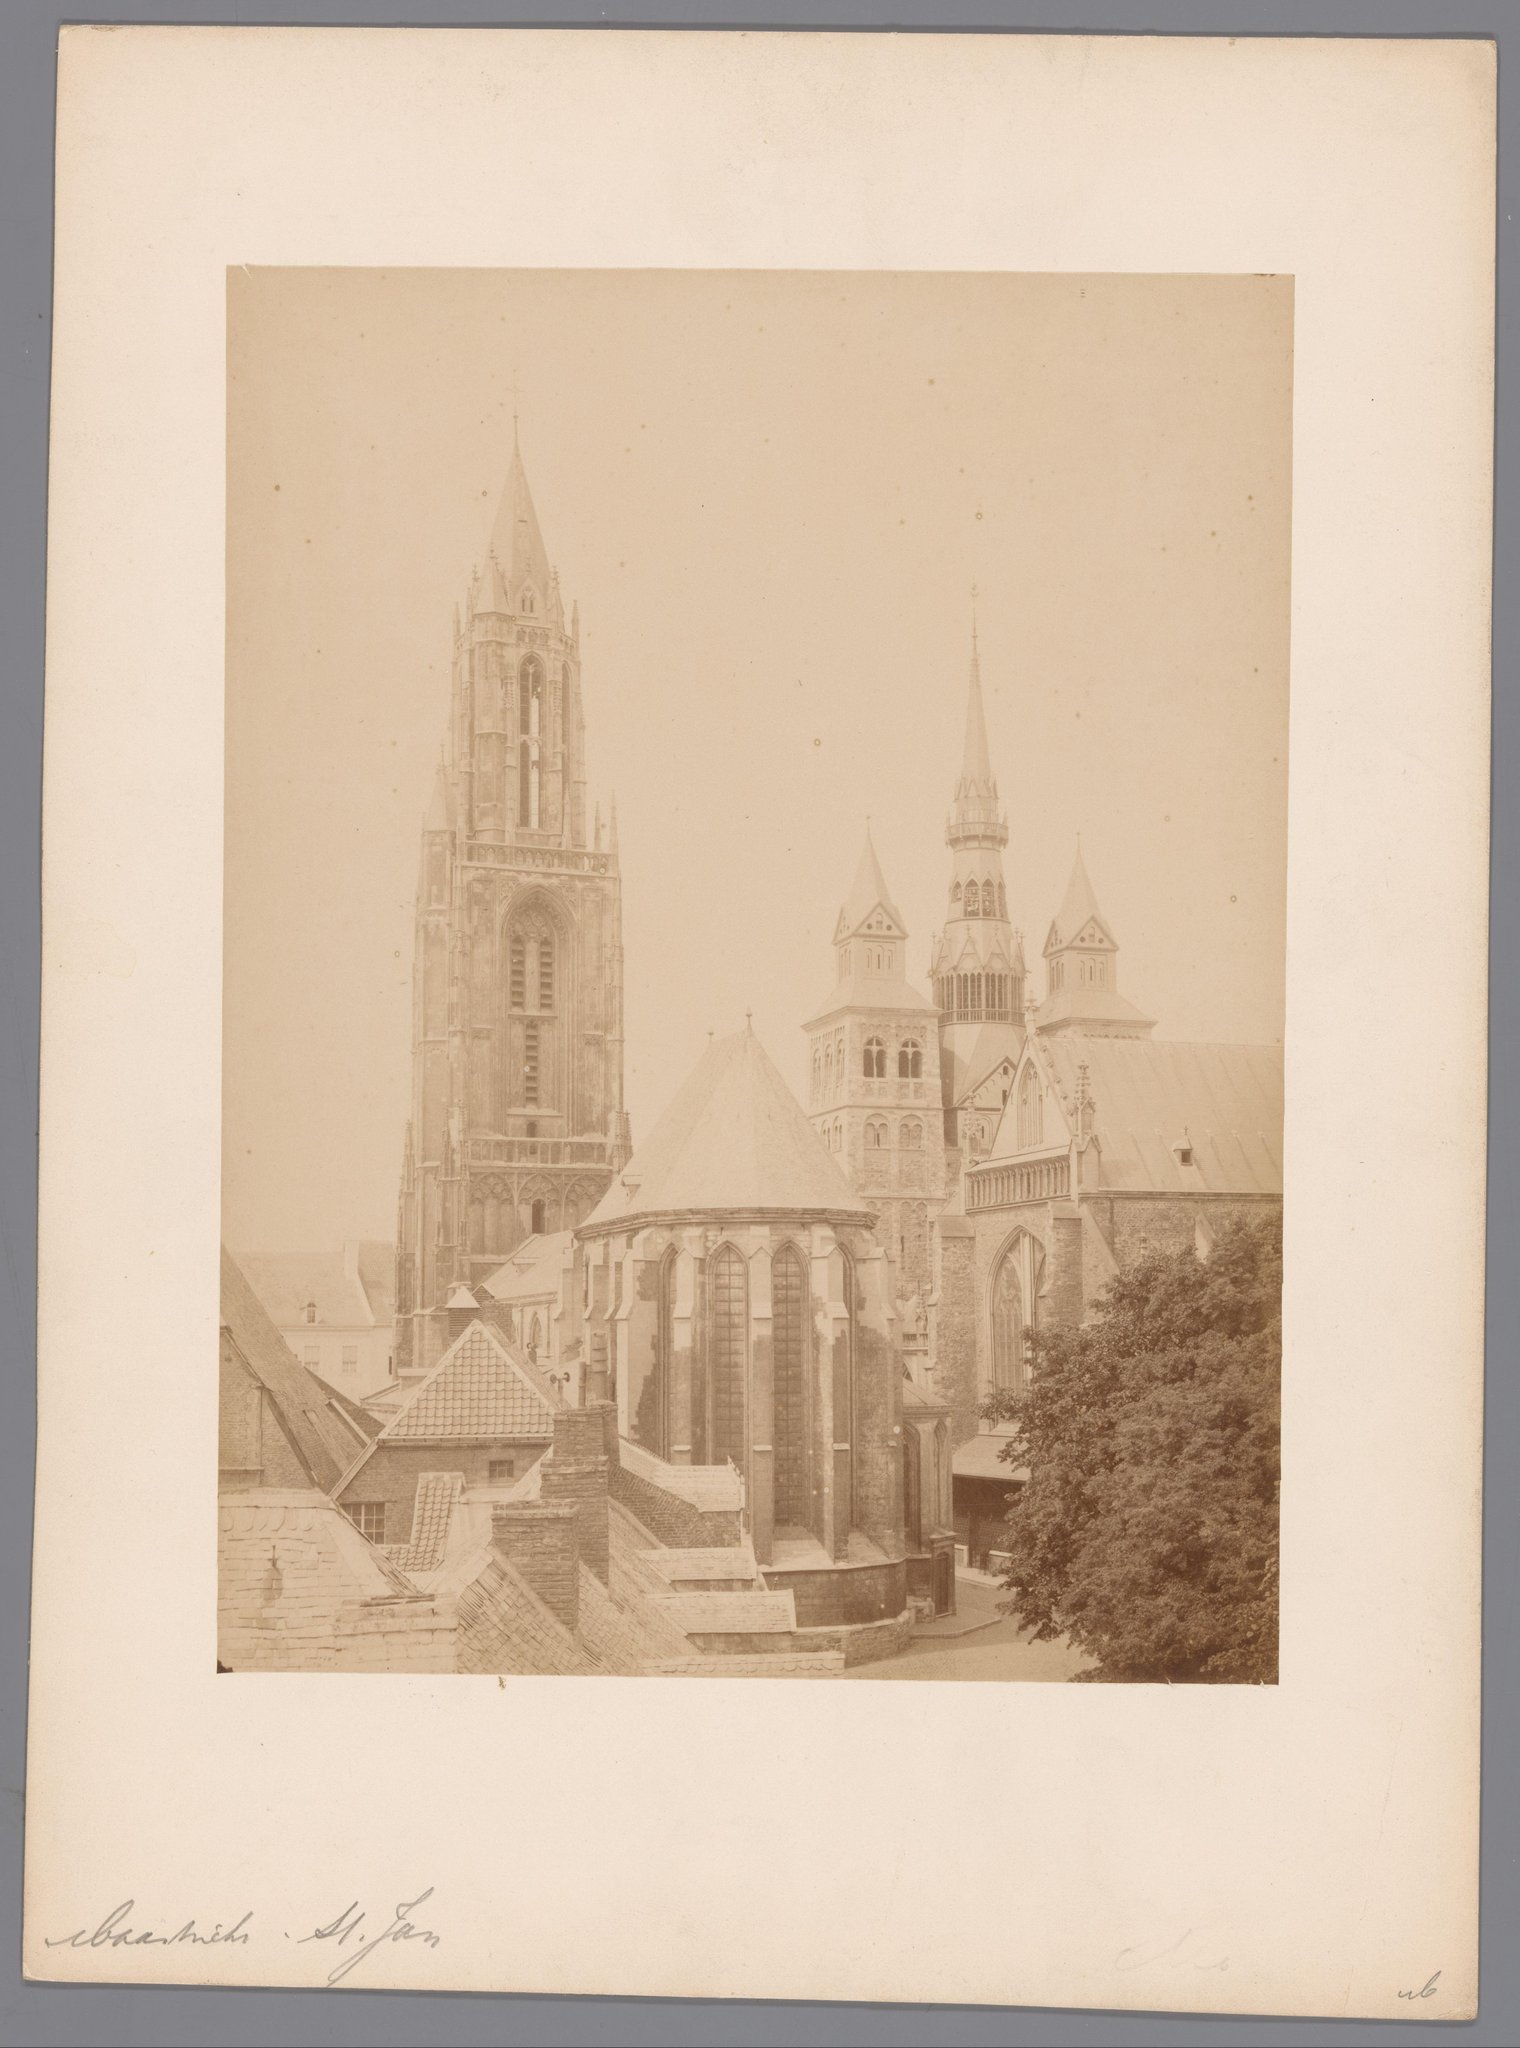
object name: photograph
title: Gezicht op de Sint-Servaasbasiliek en de Sint-Janskerk te Maastricht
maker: anoniem (monumentenzorg)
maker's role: fotograaf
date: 1893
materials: cardboard, photographic support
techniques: albumen print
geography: maastricht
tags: church (exterior)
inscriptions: annotation: ‘Maastricht St. Jan’, annotation: ‘Maastricht/ St. Servaas & St. Janskerk/ gezien van het zuid-oosten/ Mei 1893’